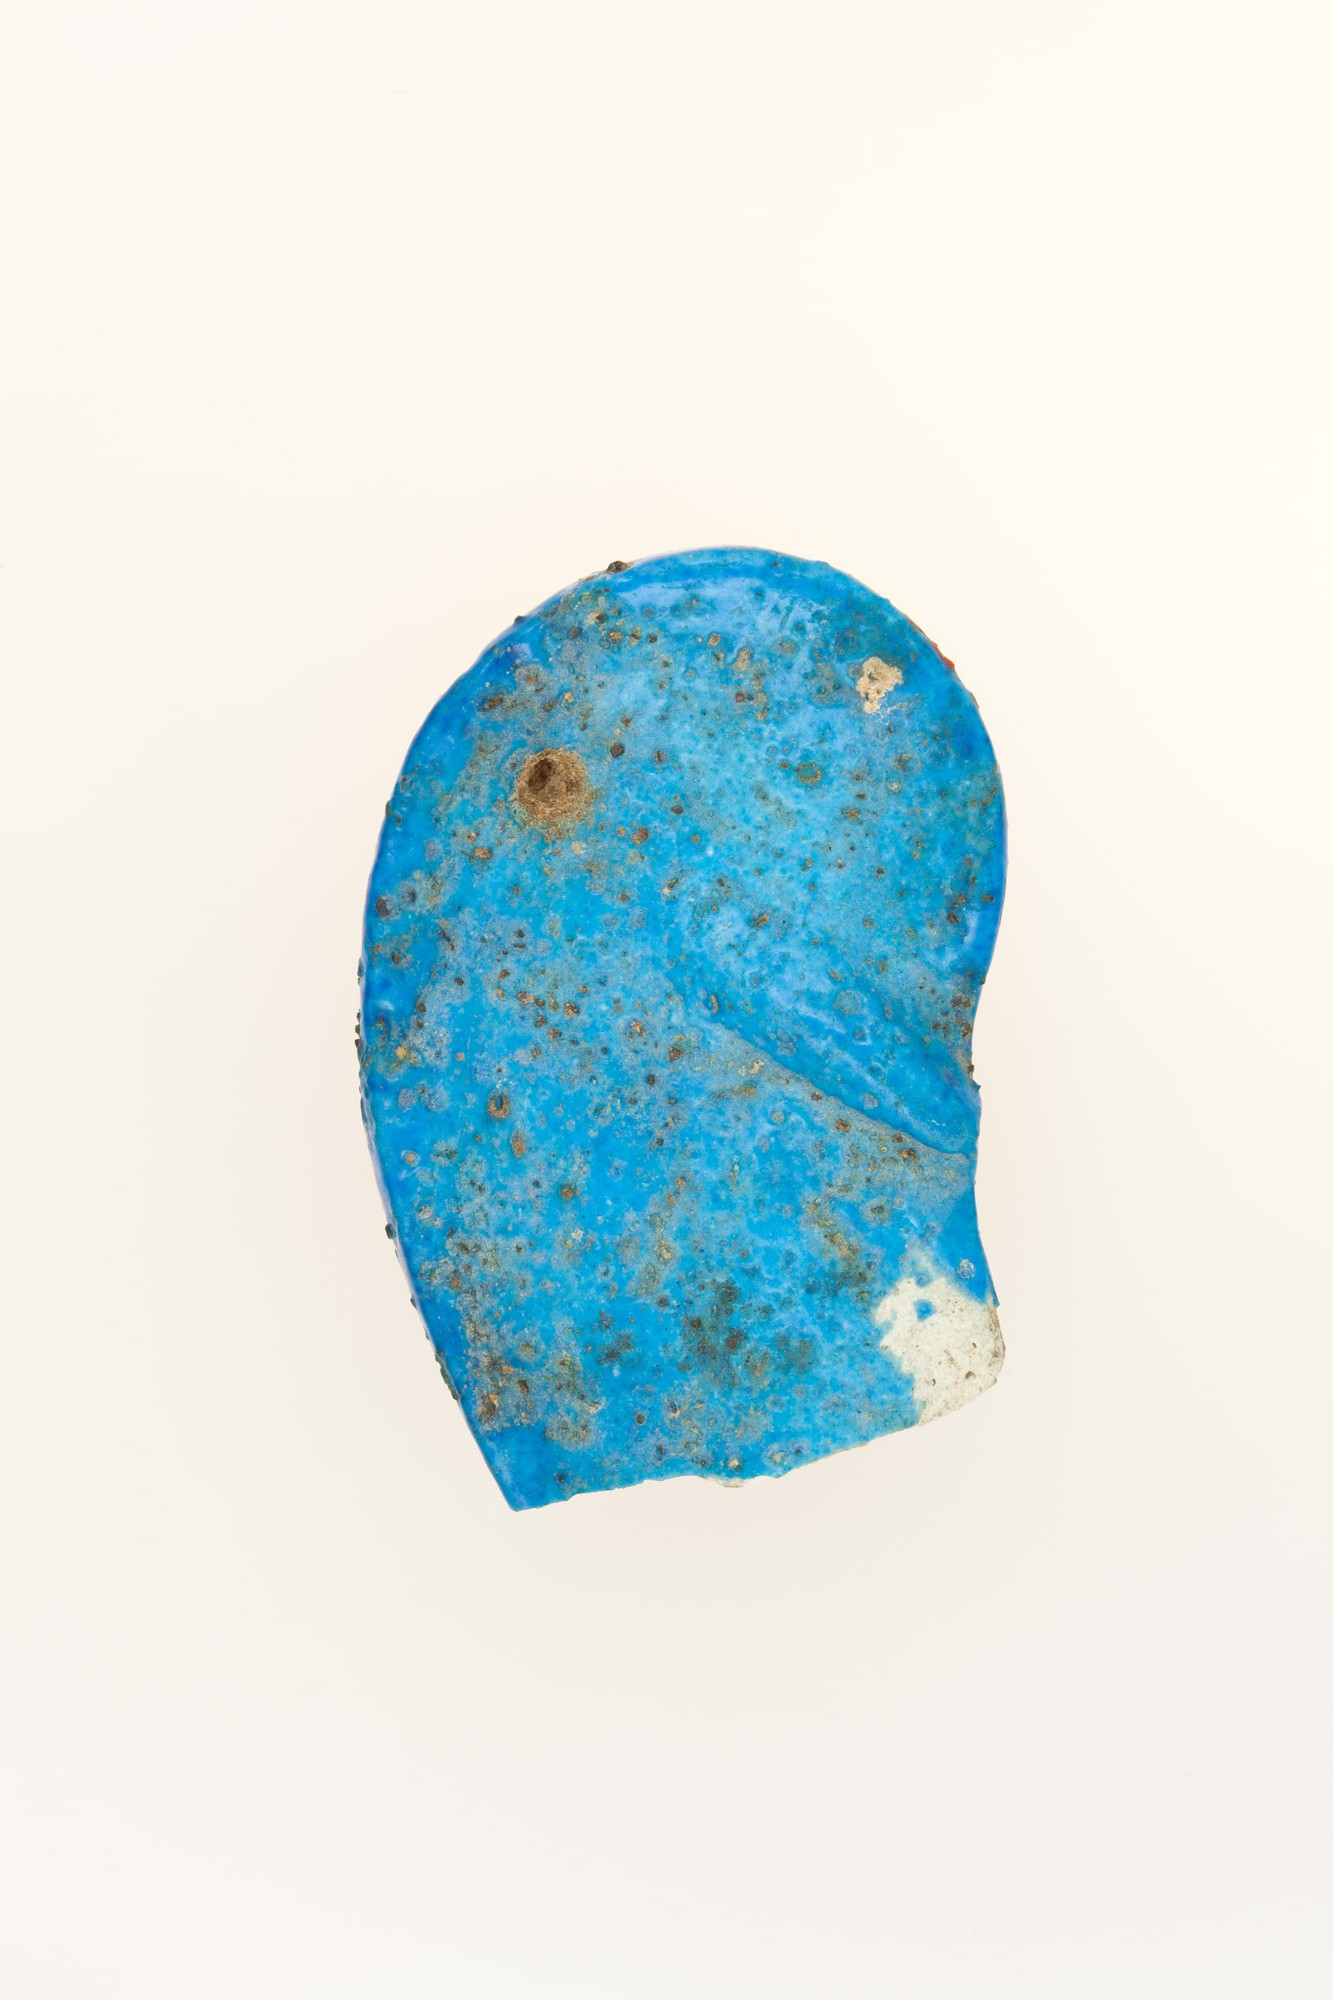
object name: amulet, ear plaque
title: Votive Ear fragment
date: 1479-1458 BCE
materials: faience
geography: egypt